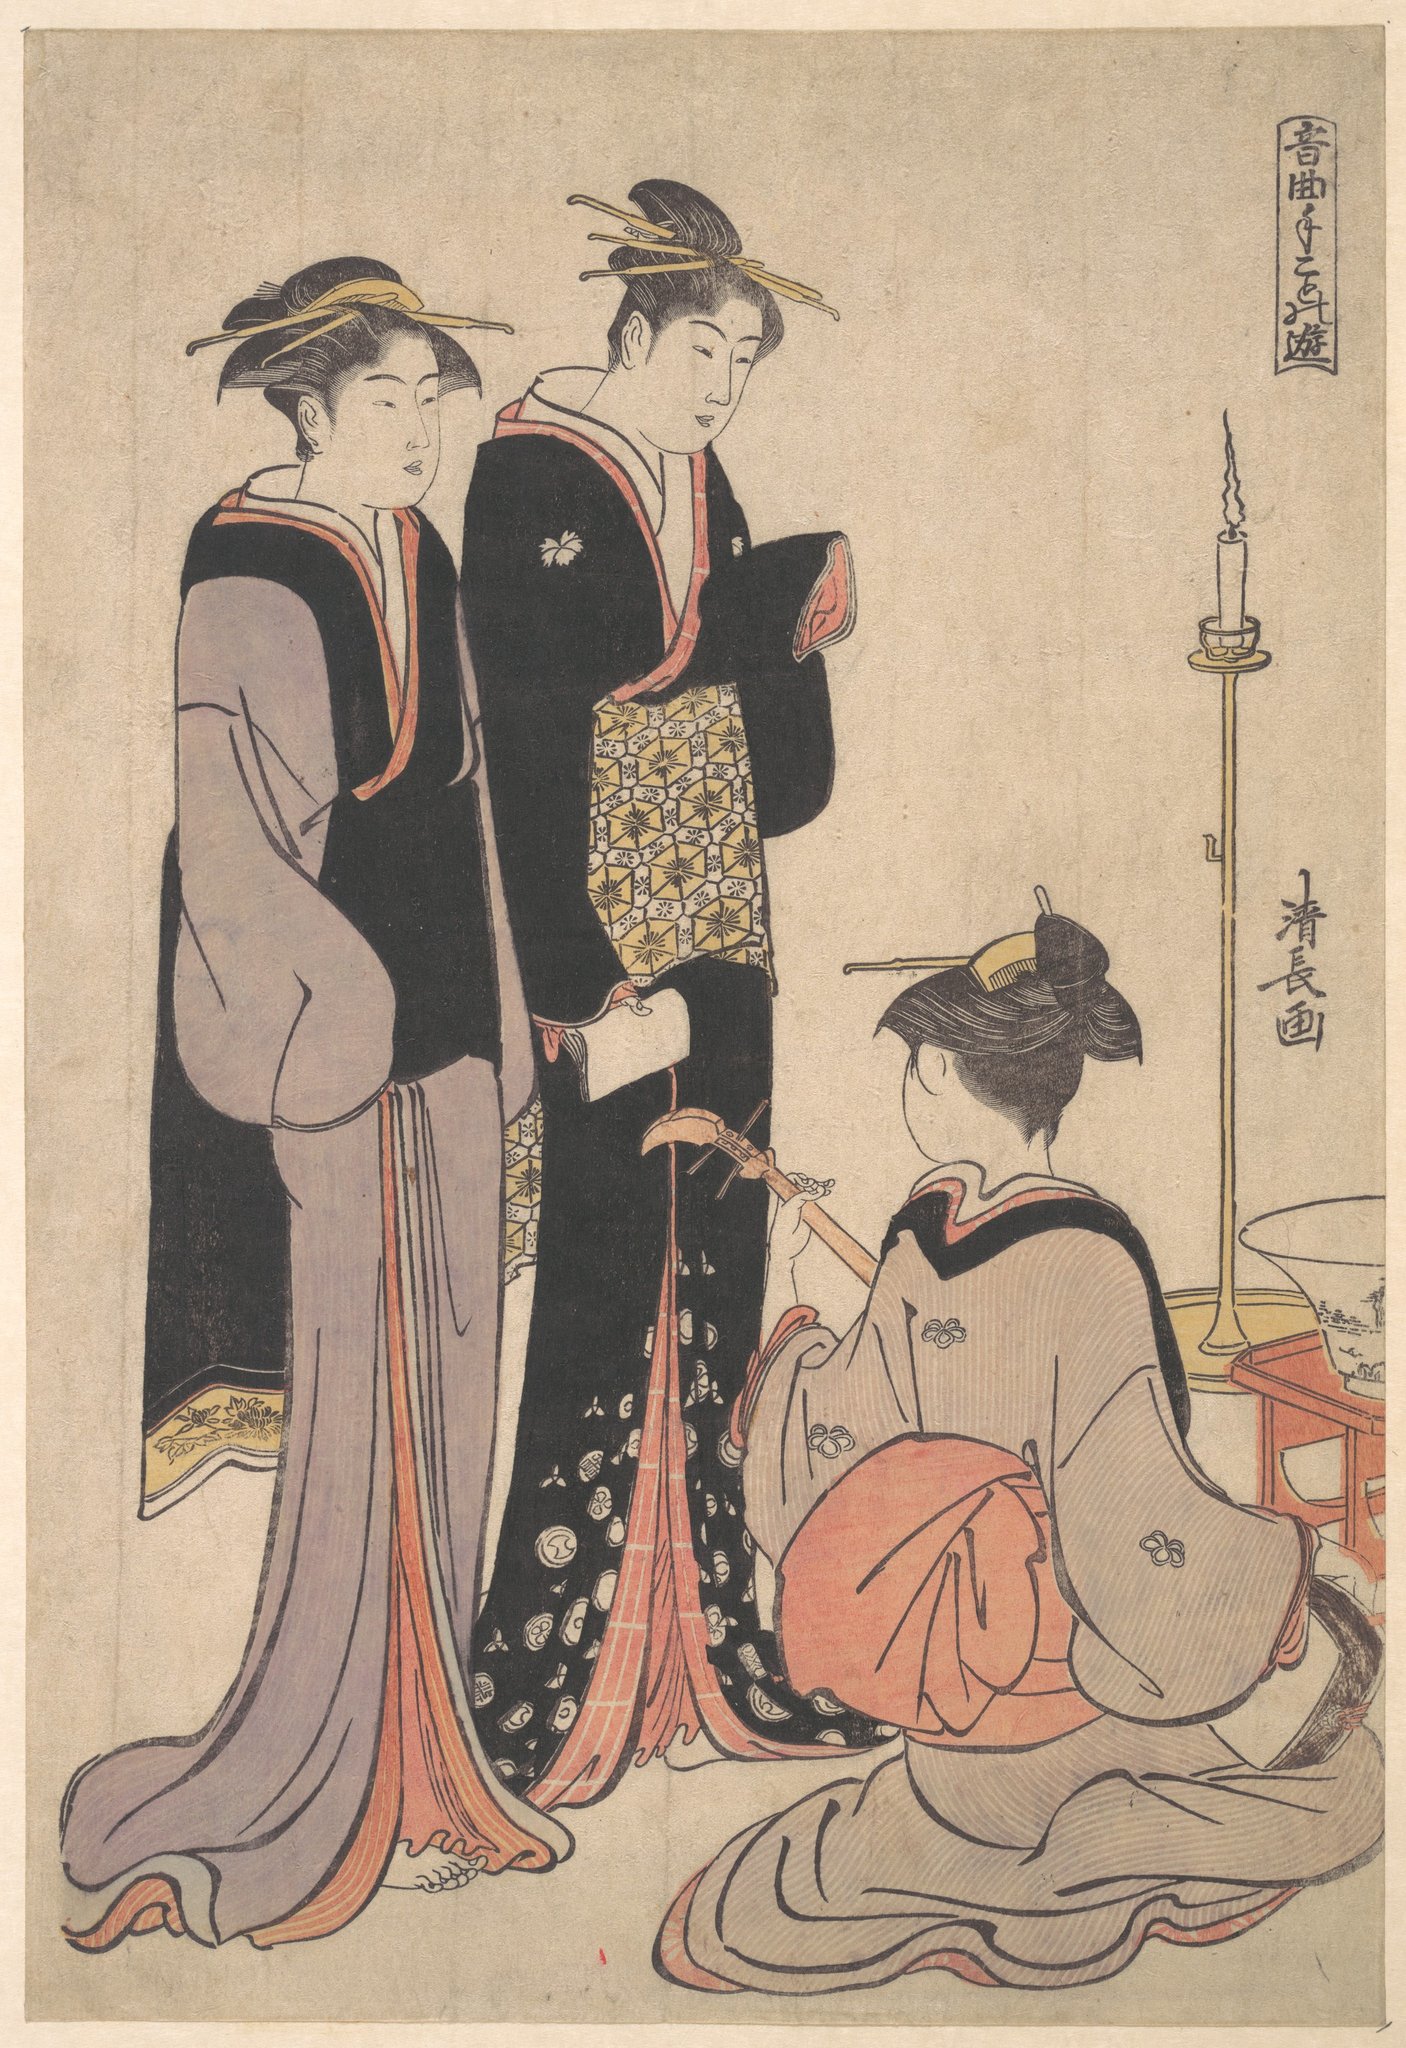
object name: print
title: Two Courtesans and a Geisha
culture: japanese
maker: torii kiyonaga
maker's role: artist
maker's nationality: japanese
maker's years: 1752-1815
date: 1783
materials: ink, paper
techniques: woodblock print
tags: women